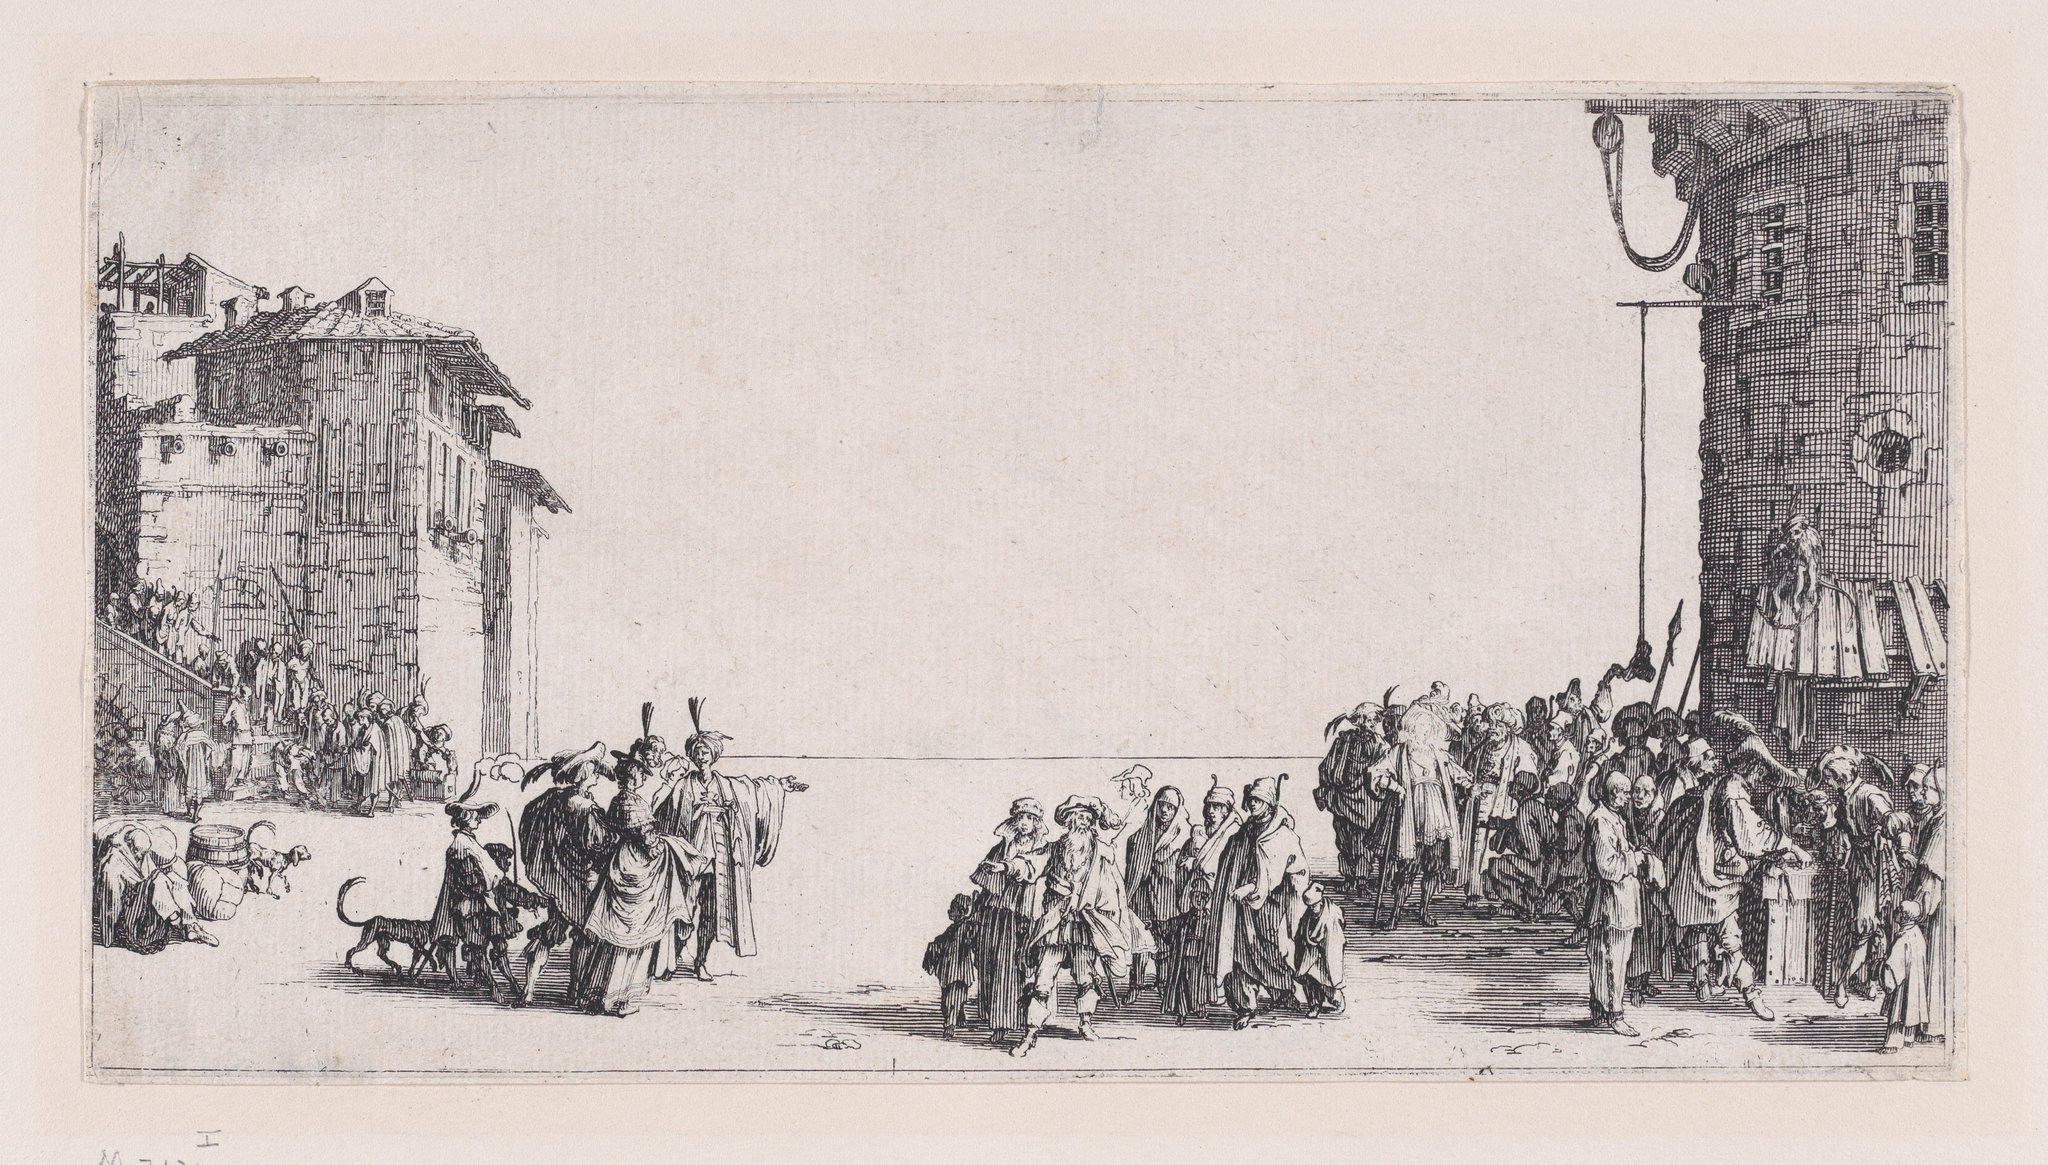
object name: print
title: The Slave Market (Le Marché d'esclaves)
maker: jacques callot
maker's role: artist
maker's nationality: french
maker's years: 1592-1635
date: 1601-1633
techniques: etching